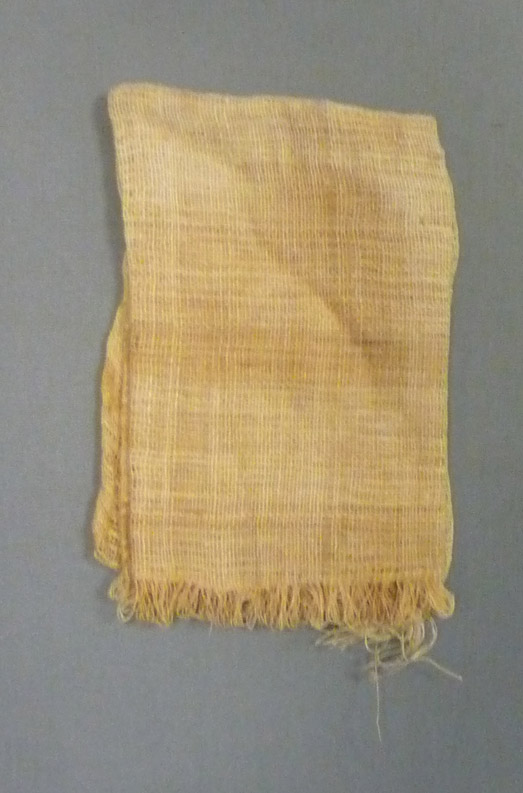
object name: linen ritual cloth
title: Miniature Linen Sheet From Foundation Deposit 2 of Hatshepsut's Valley Temple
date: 1479-1458 BCE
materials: linen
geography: egypt